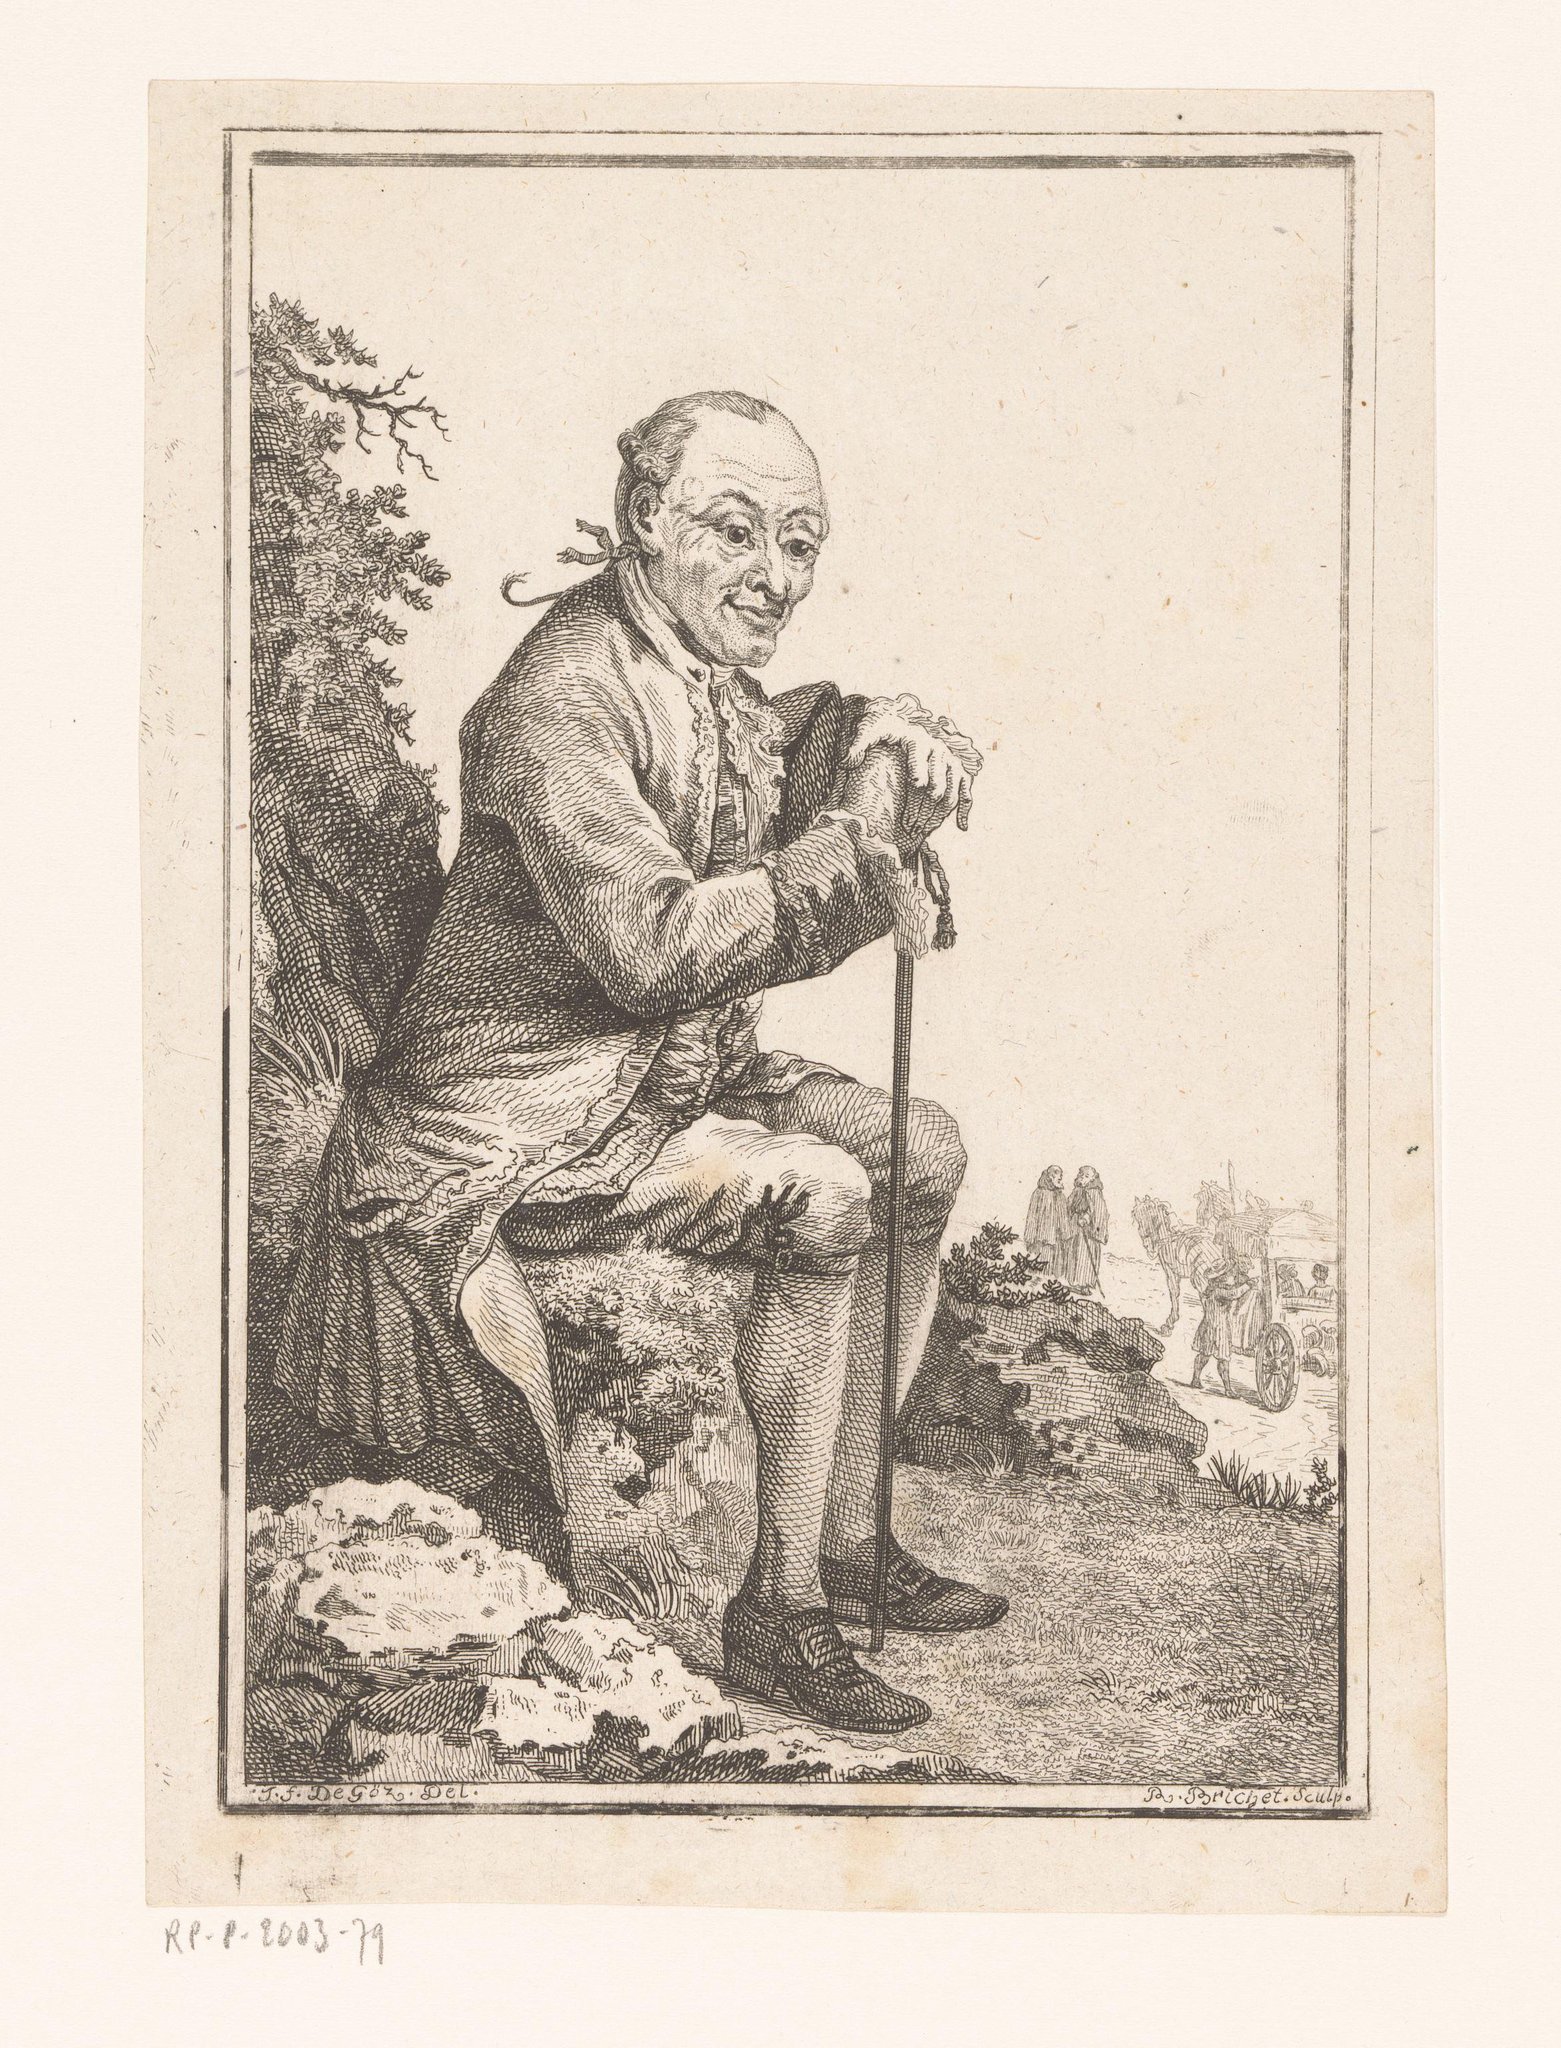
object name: print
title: Zittende man met wandelstok in een landschap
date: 1783-1784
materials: paper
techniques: etching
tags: sitting figure, walking-stick, staff, old man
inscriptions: collector's mark: Lugt 2760, collector's mark: Lugt 2228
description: Prent uit een serie getiteld: "Exercises d'imagination de differens Caractères et Formes humaines inventés peints et dessinés par J. F. de Goez Suite 1", bestaande uit honderd platen met verschillende figuren met elk een eigen titel. Plaat 1 t/m 84 zijn van de hand van Brichet naar ontwerp van Von Goez en plaat 85 t/m 100 zijn door Von Goez zelf geëtst.